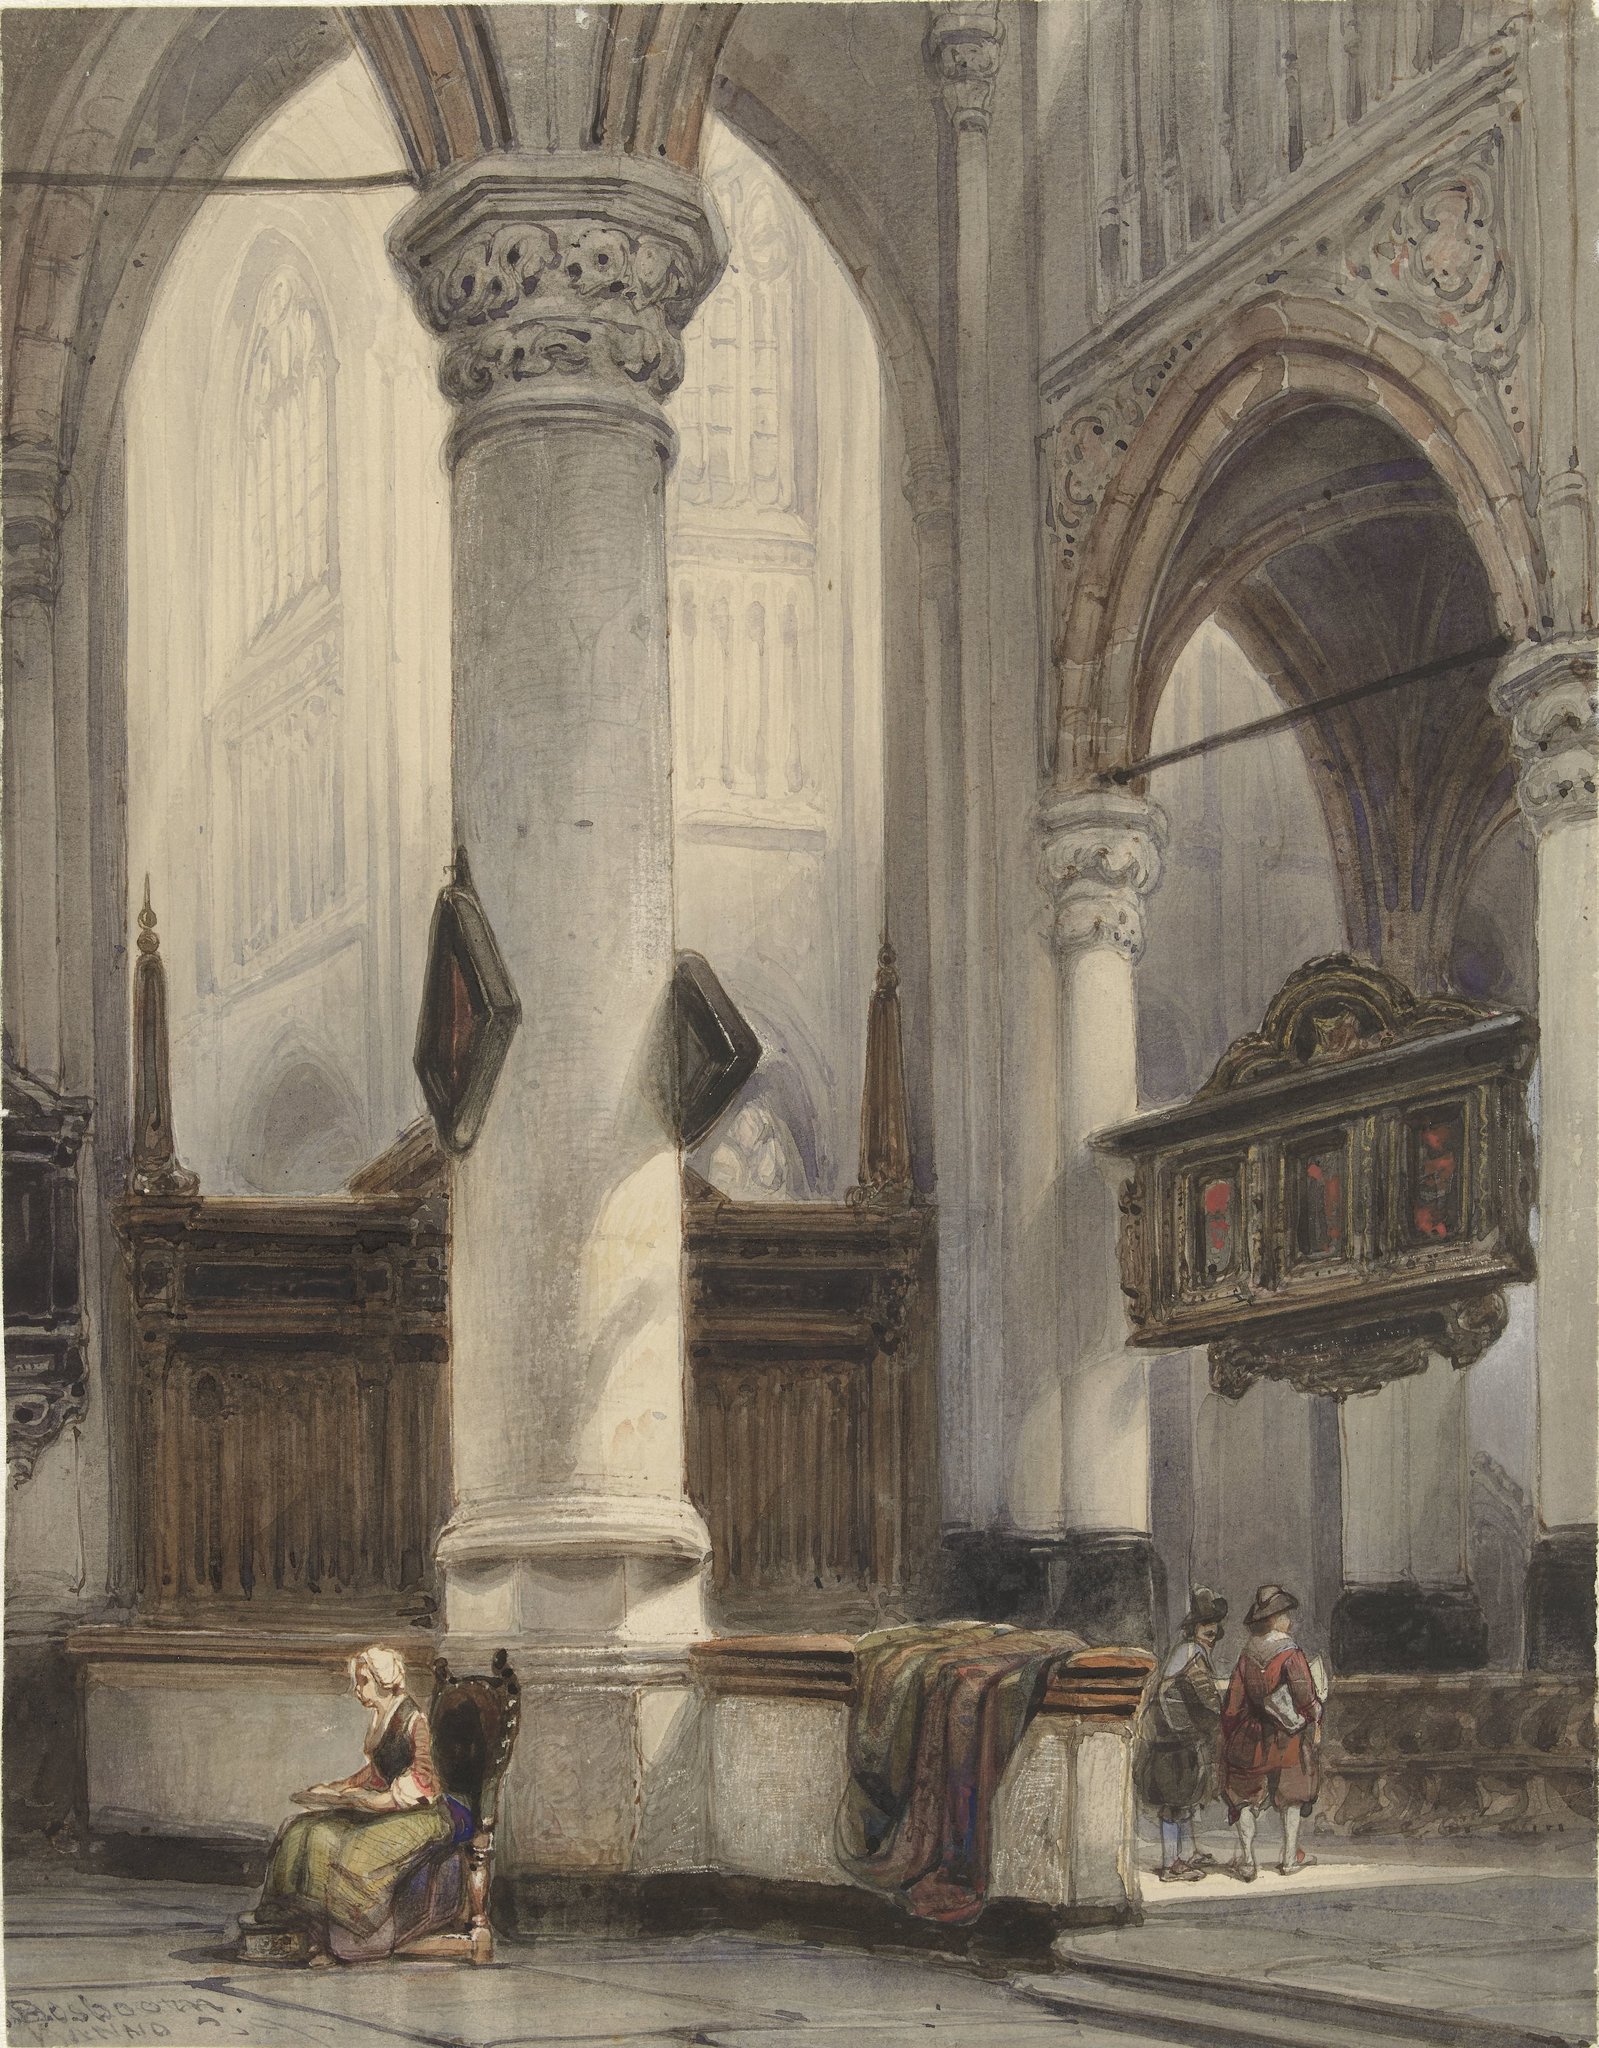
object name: watercolor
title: Interieur van de Nieuwe Kerk te Delft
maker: johannes bosboom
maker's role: draughtsman, painter, print maker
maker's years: 1817-1891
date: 1839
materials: paint, ink, paper, pencil, watercolor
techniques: brush, pen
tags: church (exterior), delft